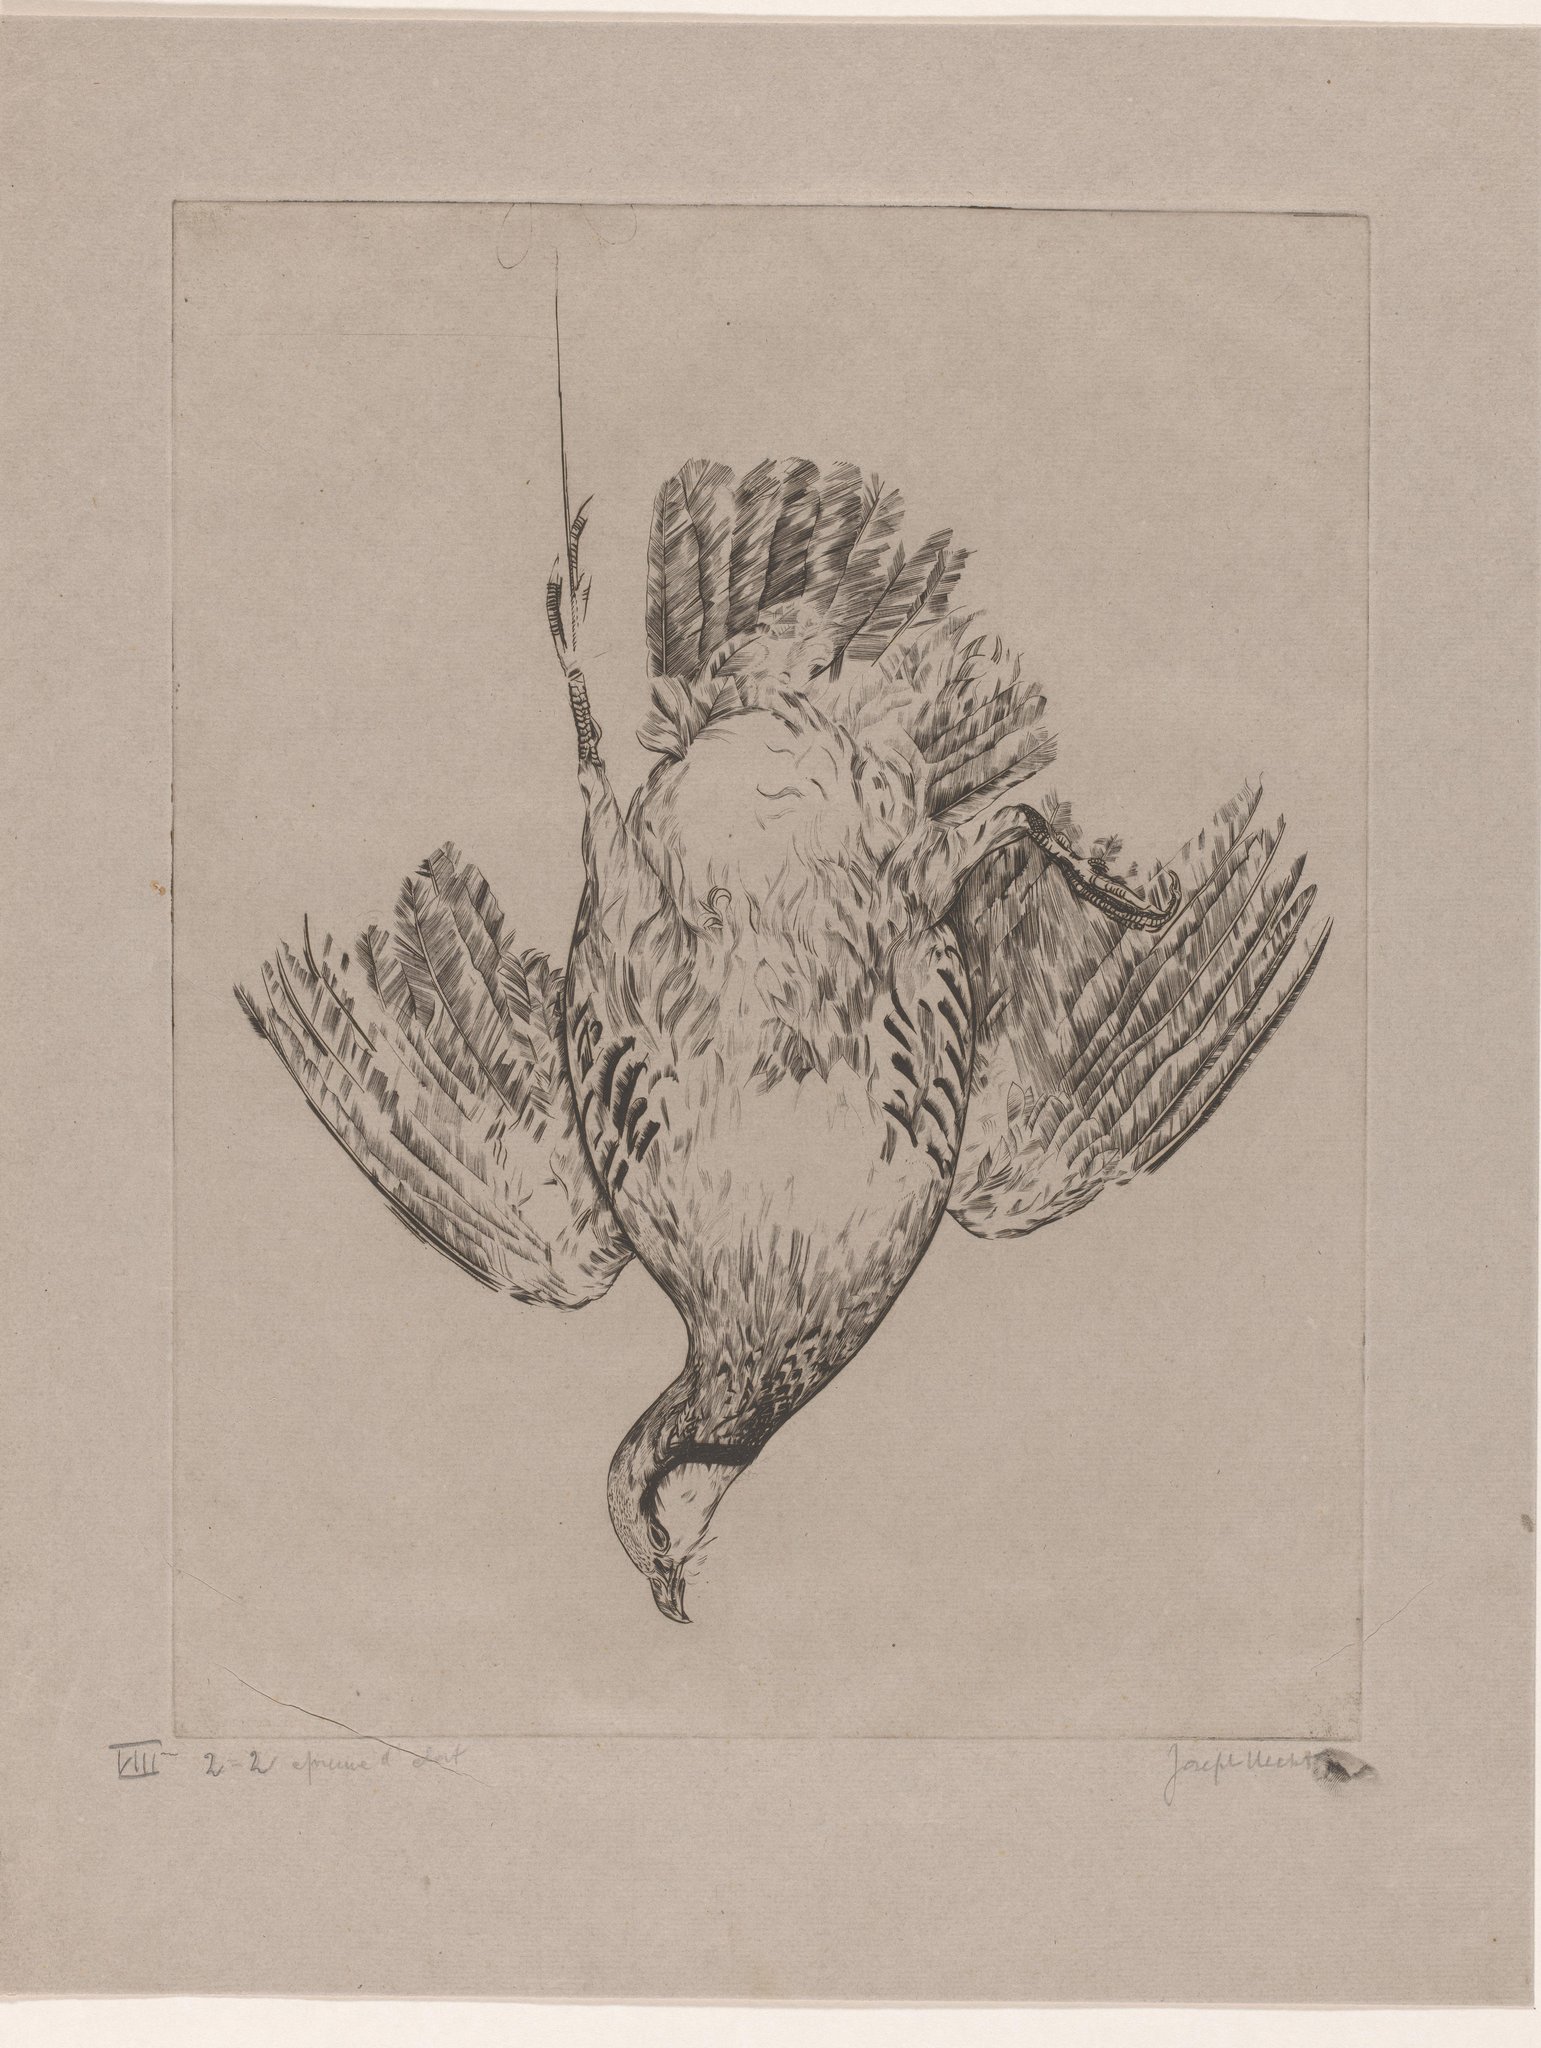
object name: print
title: Dode veldhoen, opgehangen aan één poot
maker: joseph hecht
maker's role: print maker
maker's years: 1891-1951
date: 1936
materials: paper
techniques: engraving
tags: walker and runner birds: partridge, spoils of the hunt, game, venison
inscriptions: collector's mark: Lugt 2228